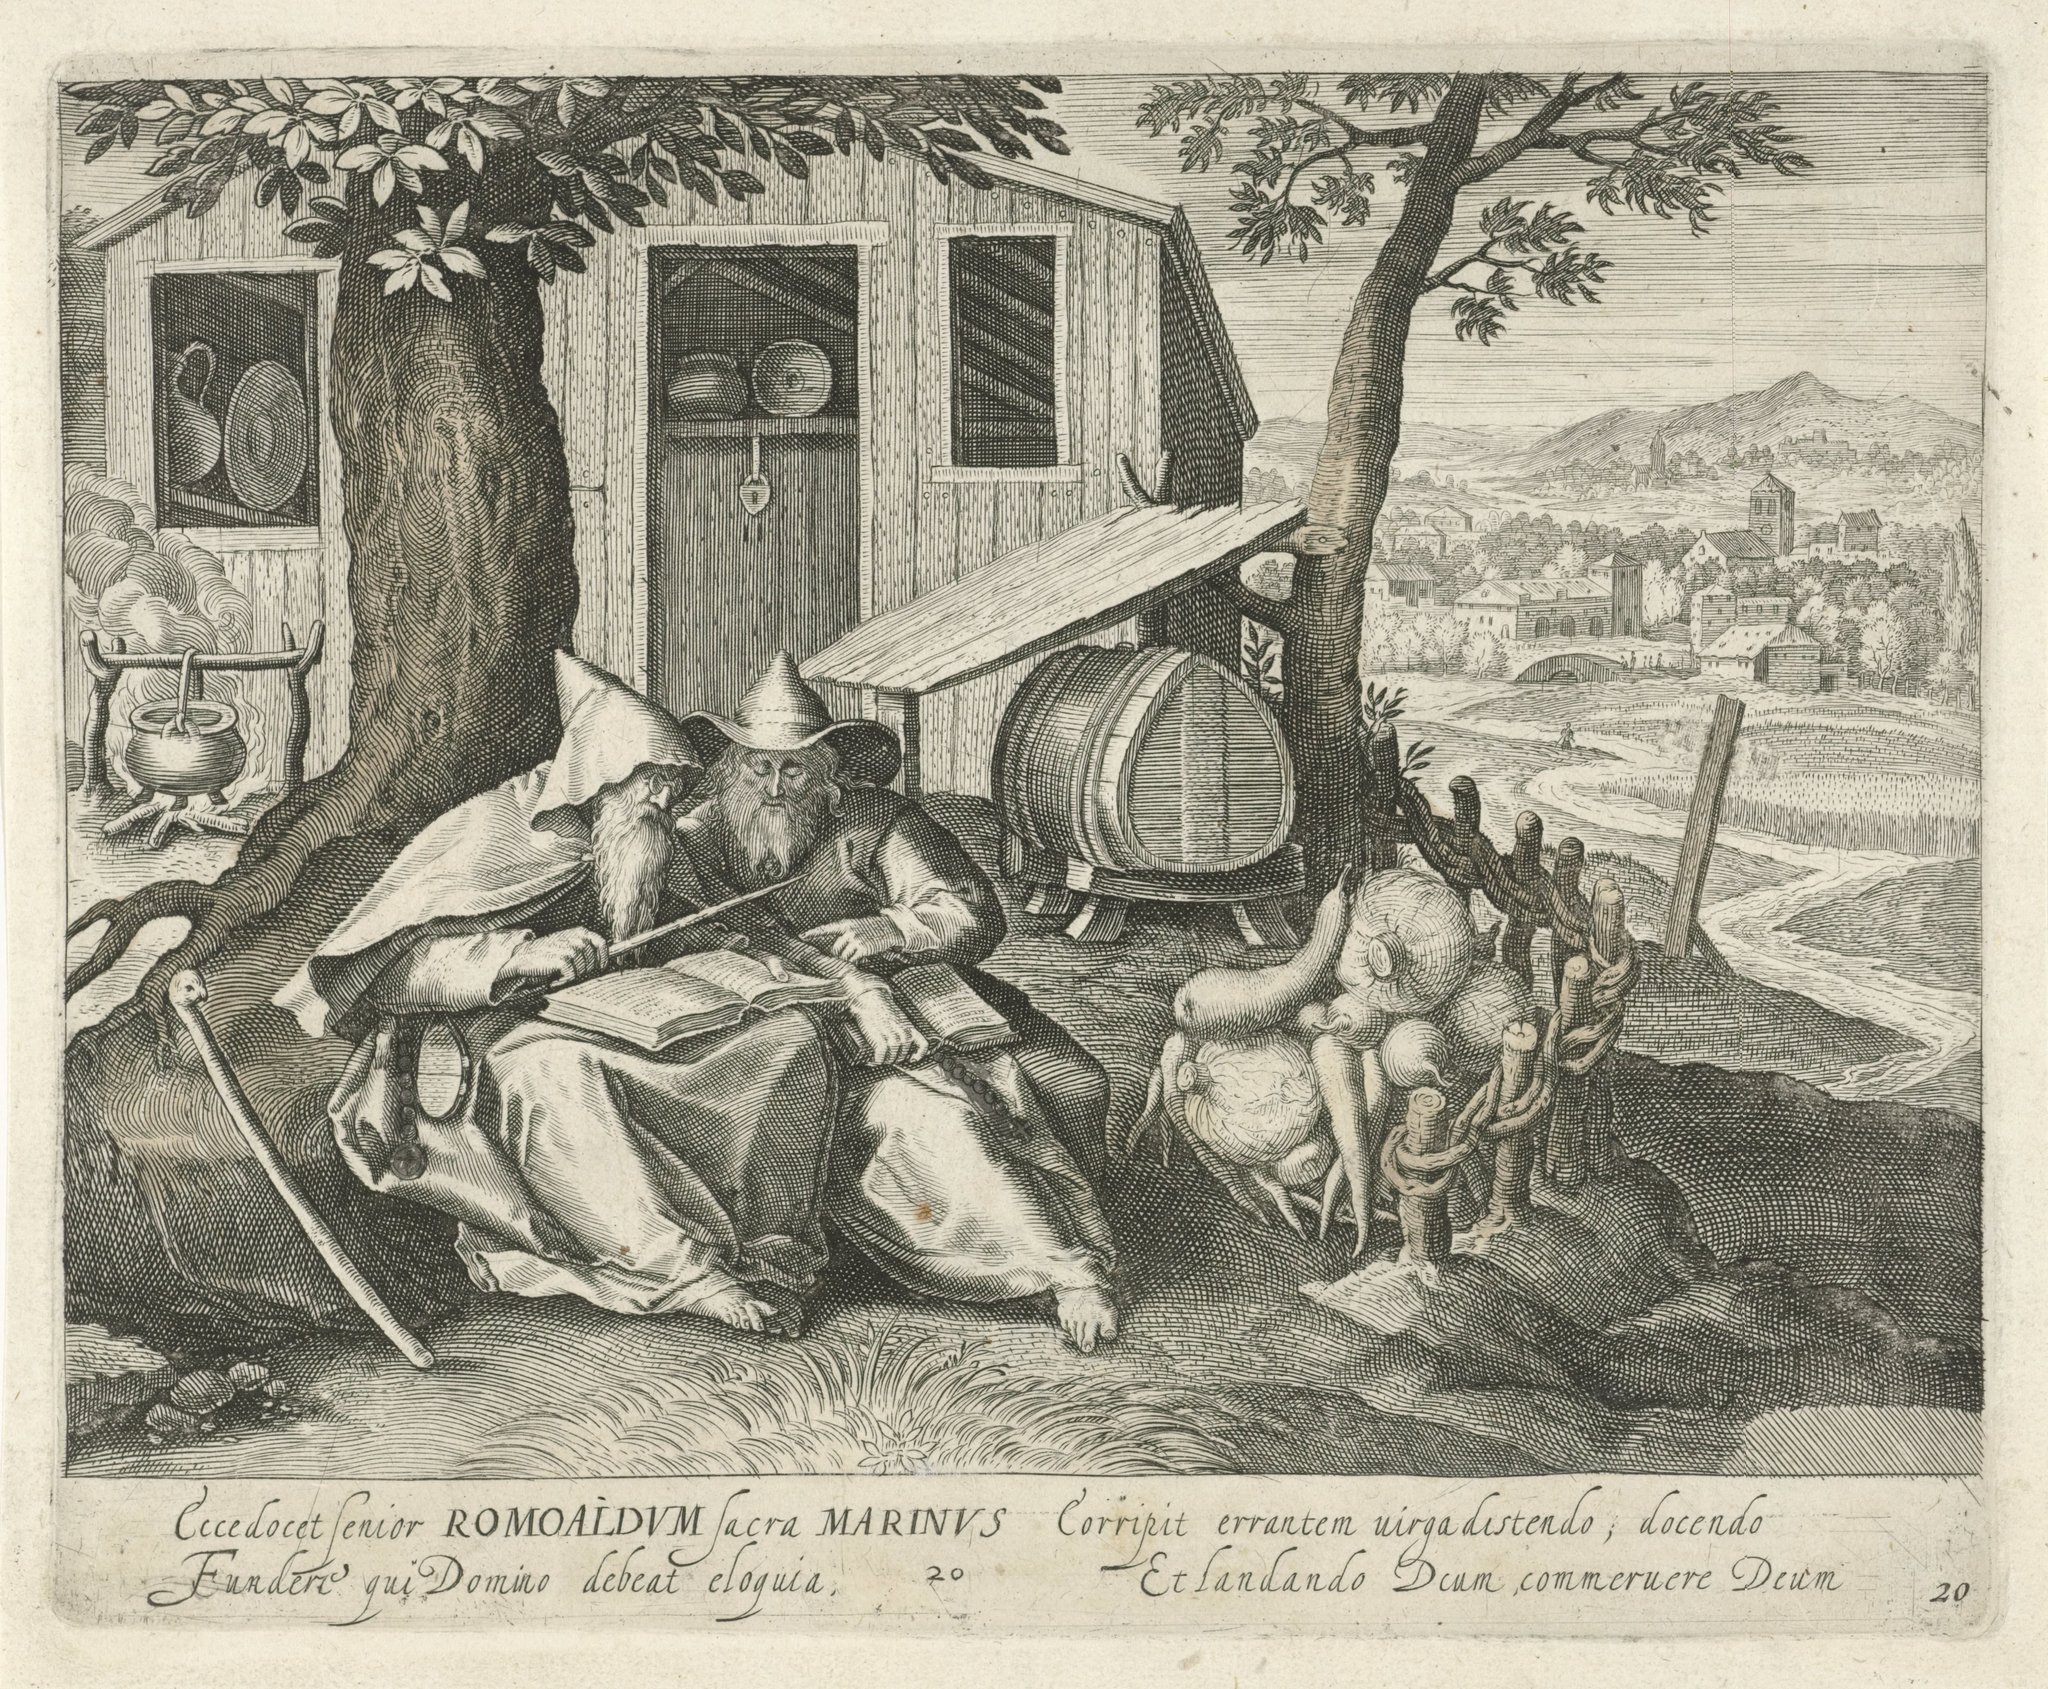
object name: print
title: Heiligen en kluizenaars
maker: jan van londerseel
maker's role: print maker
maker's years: 1570-1625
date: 1580-1625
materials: paper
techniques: brush, engraving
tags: male saints (with name), anchorite, hermit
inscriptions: collector's mark: Lugt 2228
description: De heiligen Romualdus van Ravenna en Marinus zitten voor een kluizenaarshut in de heuvels en bestuderen geschriften. In de marge een onderschrift in Latijn.